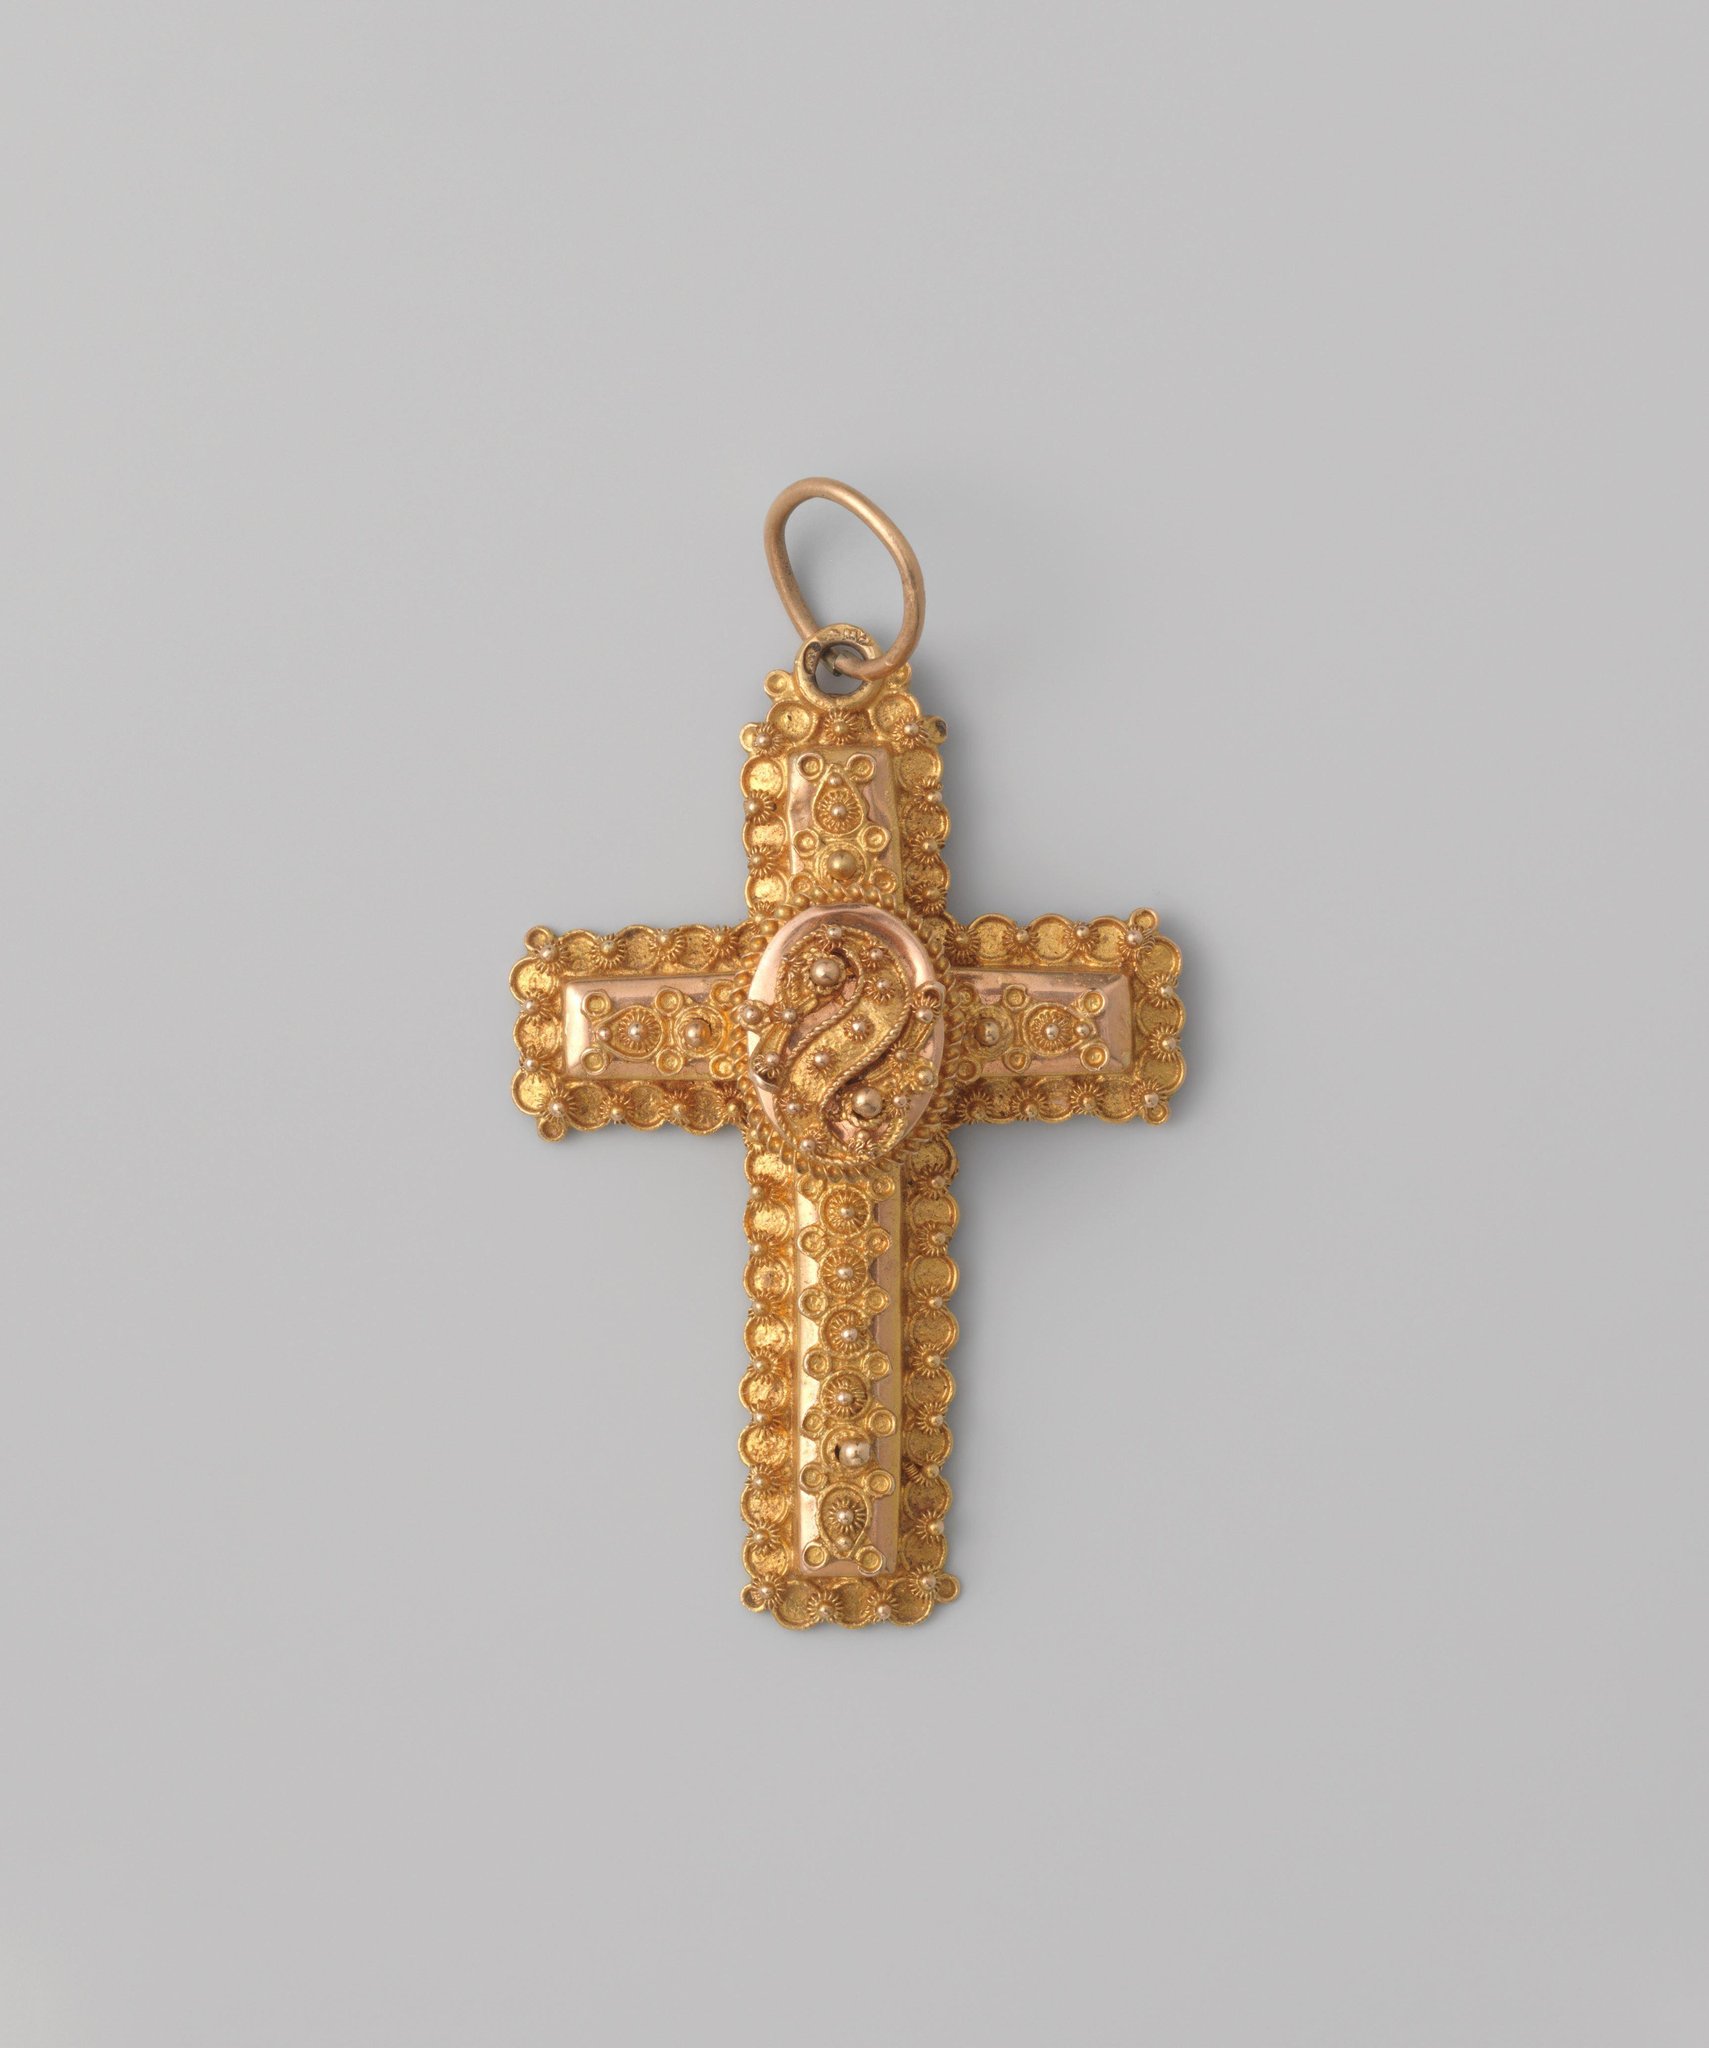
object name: pendant jewelry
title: Hanger, voornamelijk gevormd door filigrein Zeeuwse knopen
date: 1885-1900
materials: gold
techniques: filigree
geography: netherlands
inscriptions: mark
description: Hanger van goud in de vorm van een kruis. Het uit dun goud geperste kruis is versierd met filigrein, voornamelijk bestaand uit Zeeuwse knopjes. In het midden een ovale verhoging met een S-vormige versiering. Gemerkt: eikeblaadje.